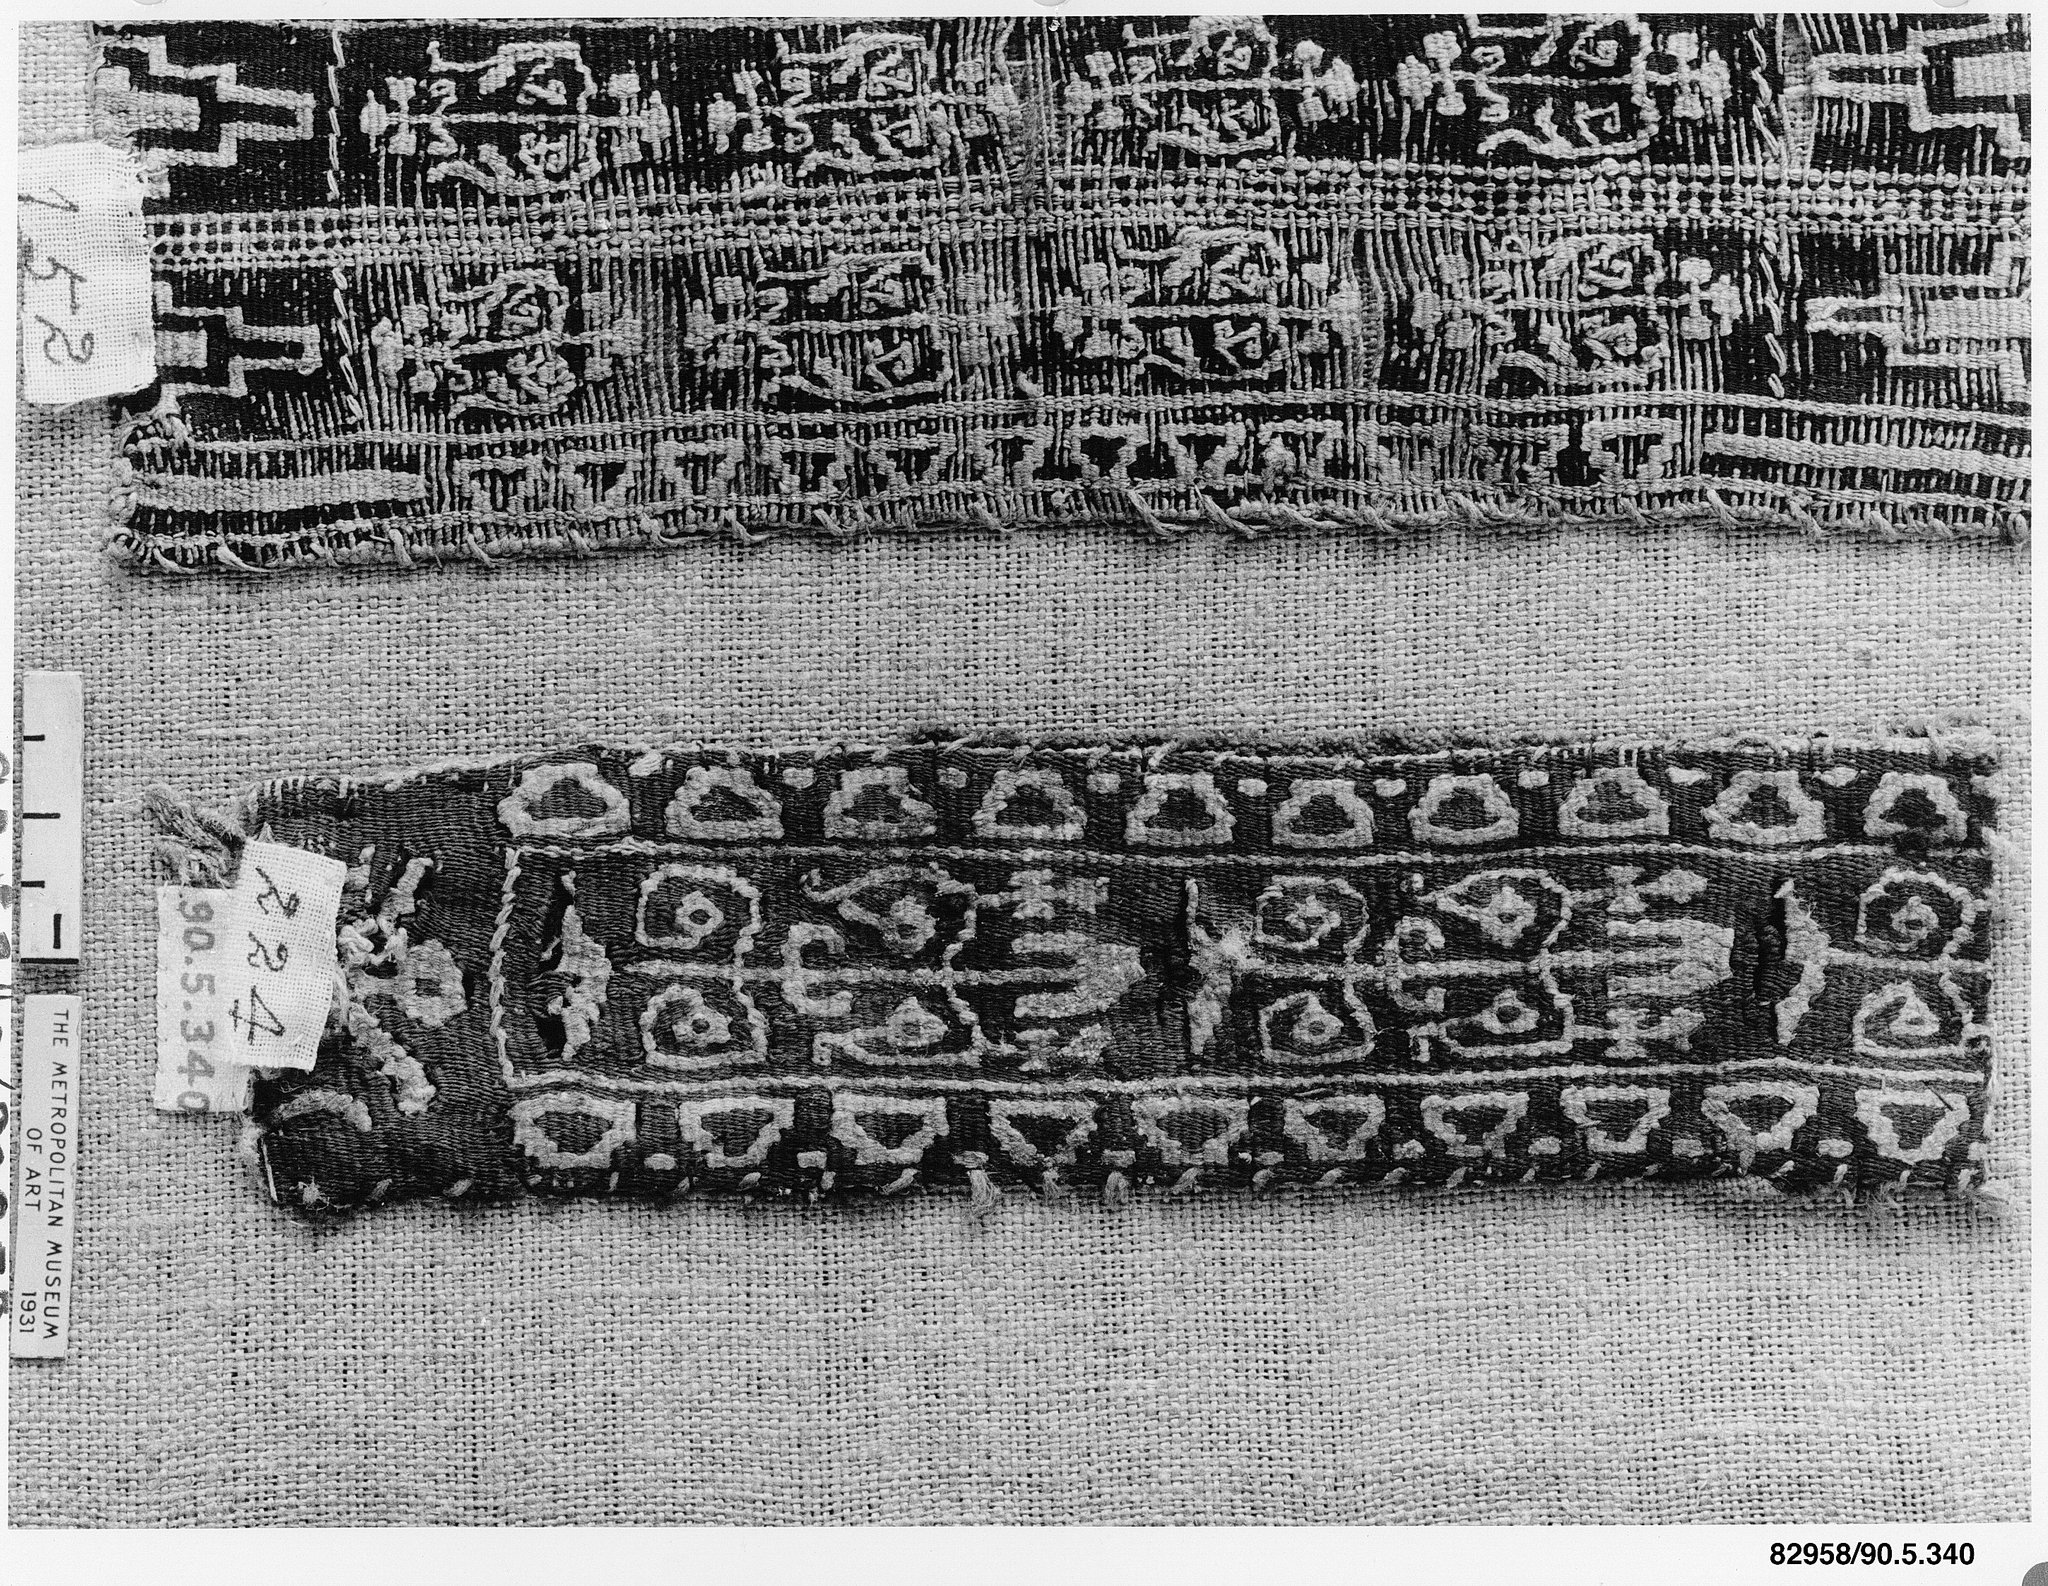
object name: textile fragment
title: Fragment of a Shoulder Band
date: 401-500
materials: linen, wool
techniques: weave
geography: egypt